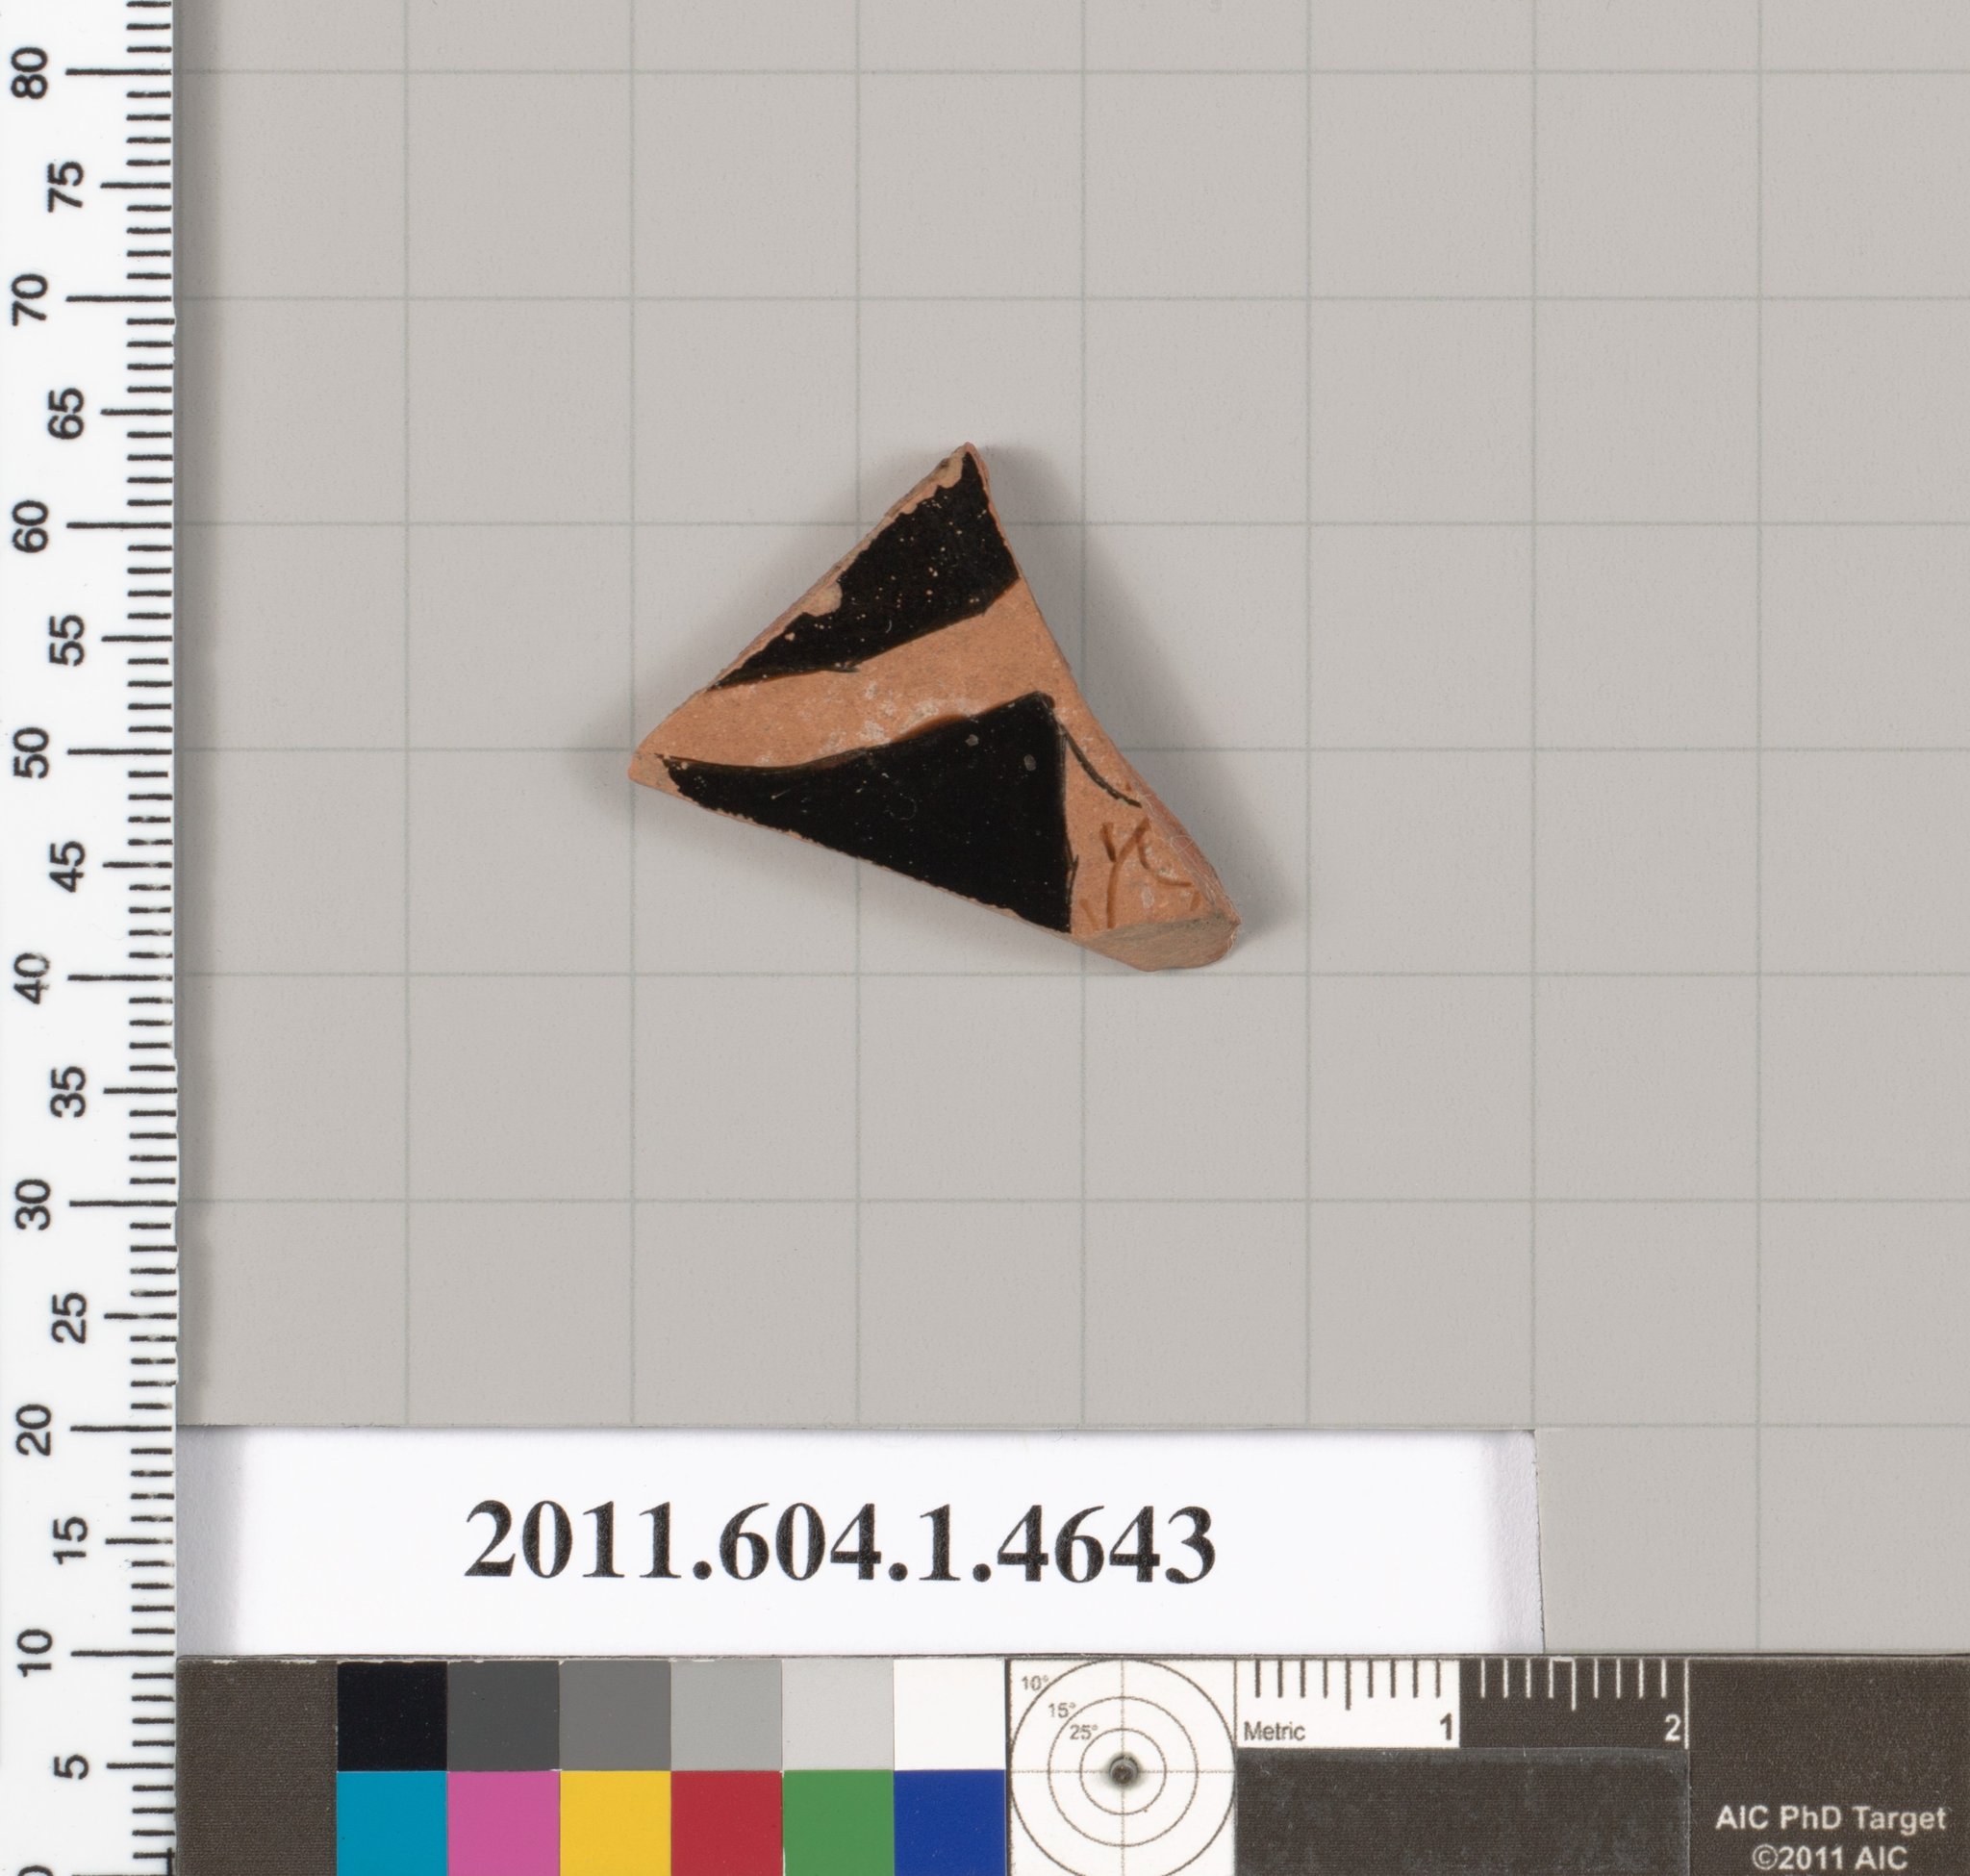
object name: kylix fragment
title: Terracotta fragment of a kylix (drinking cup)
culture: greek, attic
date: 490-470 BCE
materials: terracotta